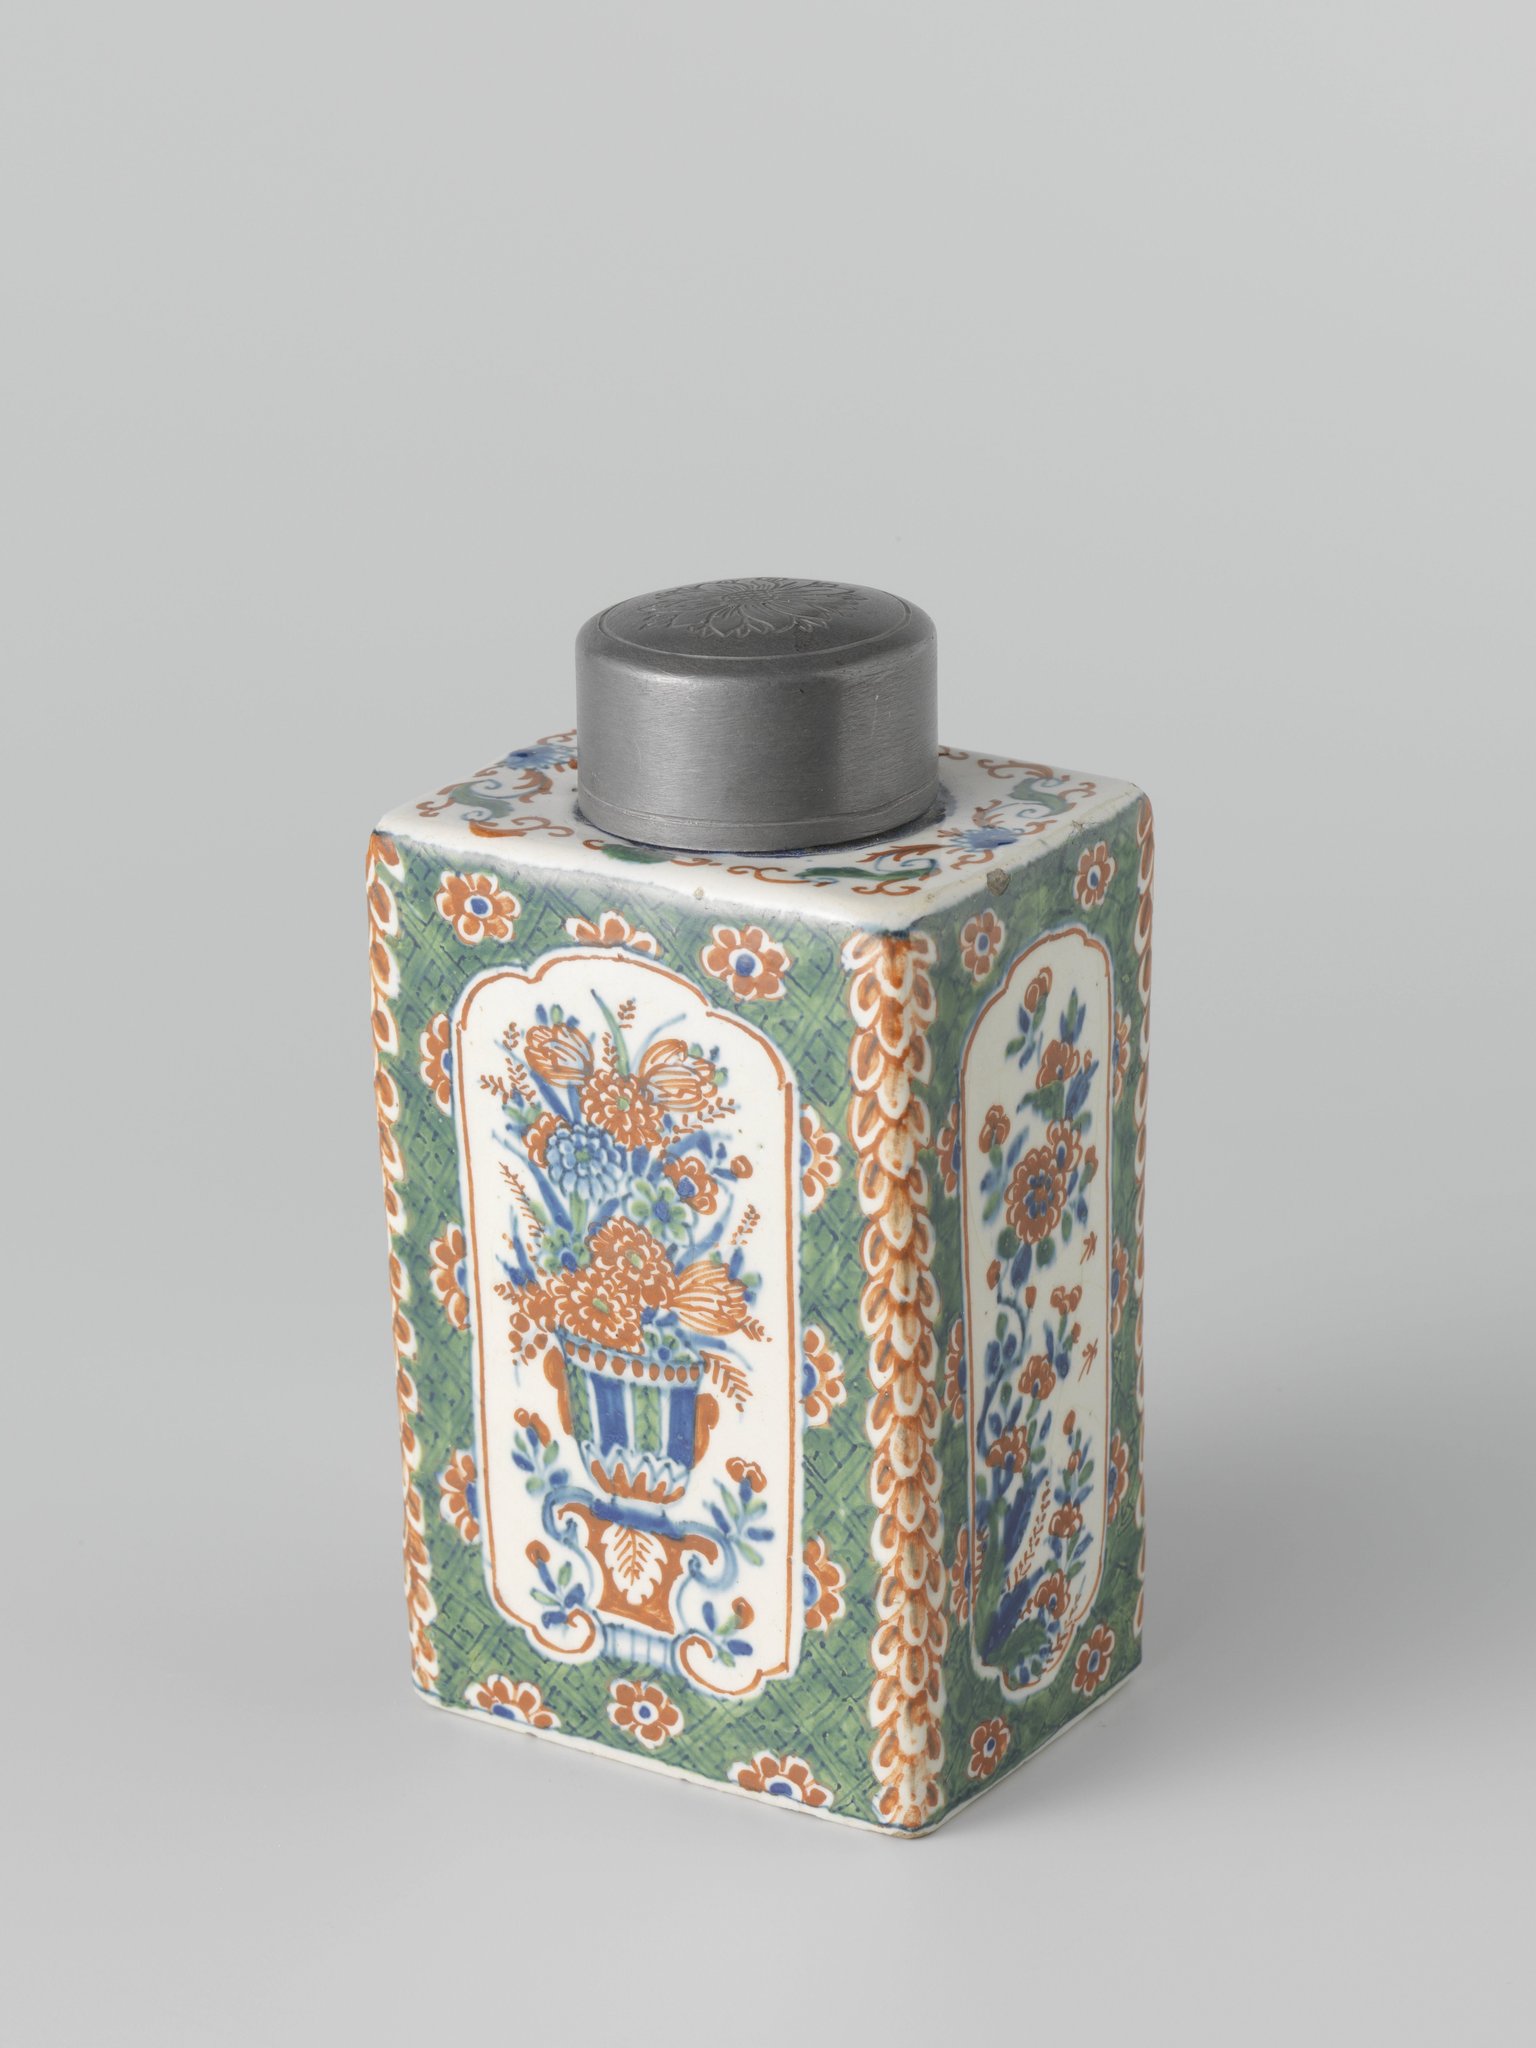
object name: tea caddy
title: Theebus met deksel van tin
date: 1500-1950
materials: earthenware, tin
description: Theebus met deksel van tin. Veelkeurig beschilderd.